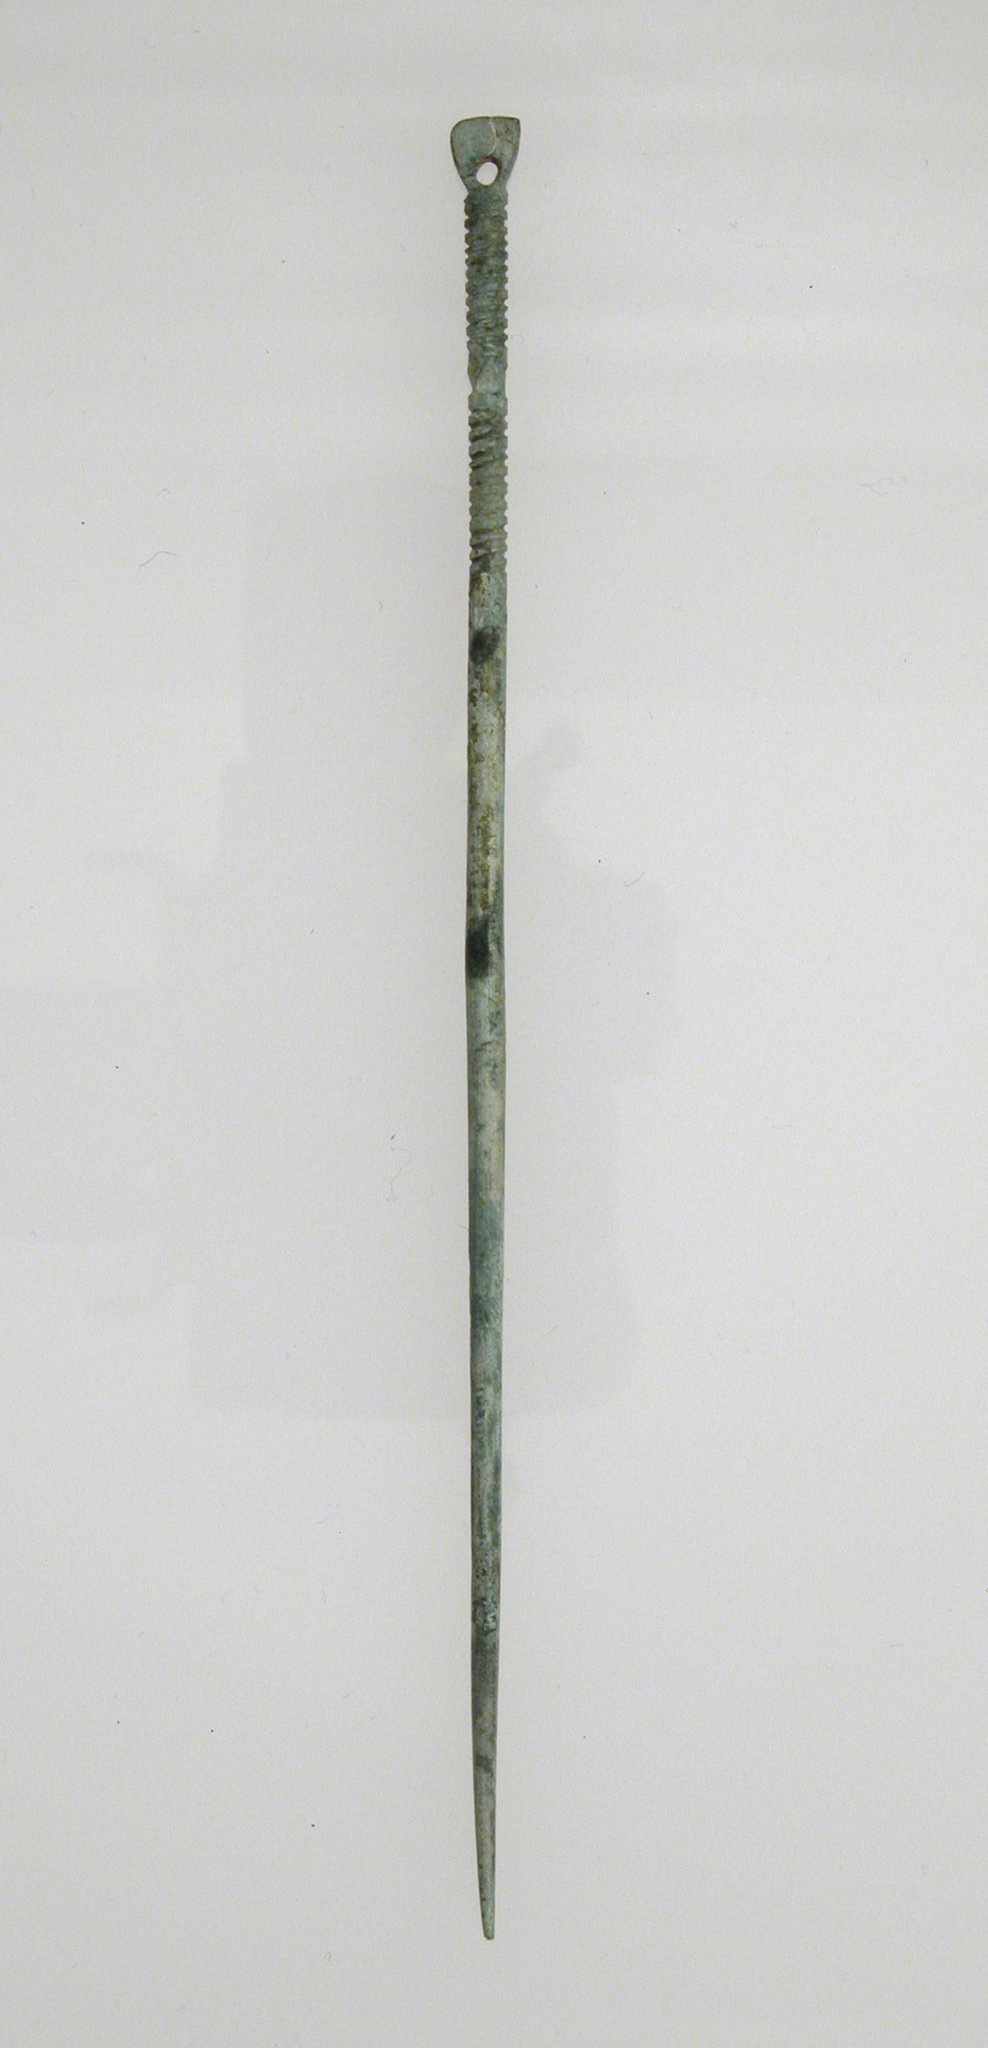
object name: hairpin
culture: frankish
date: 601-700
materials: bronze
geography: germany